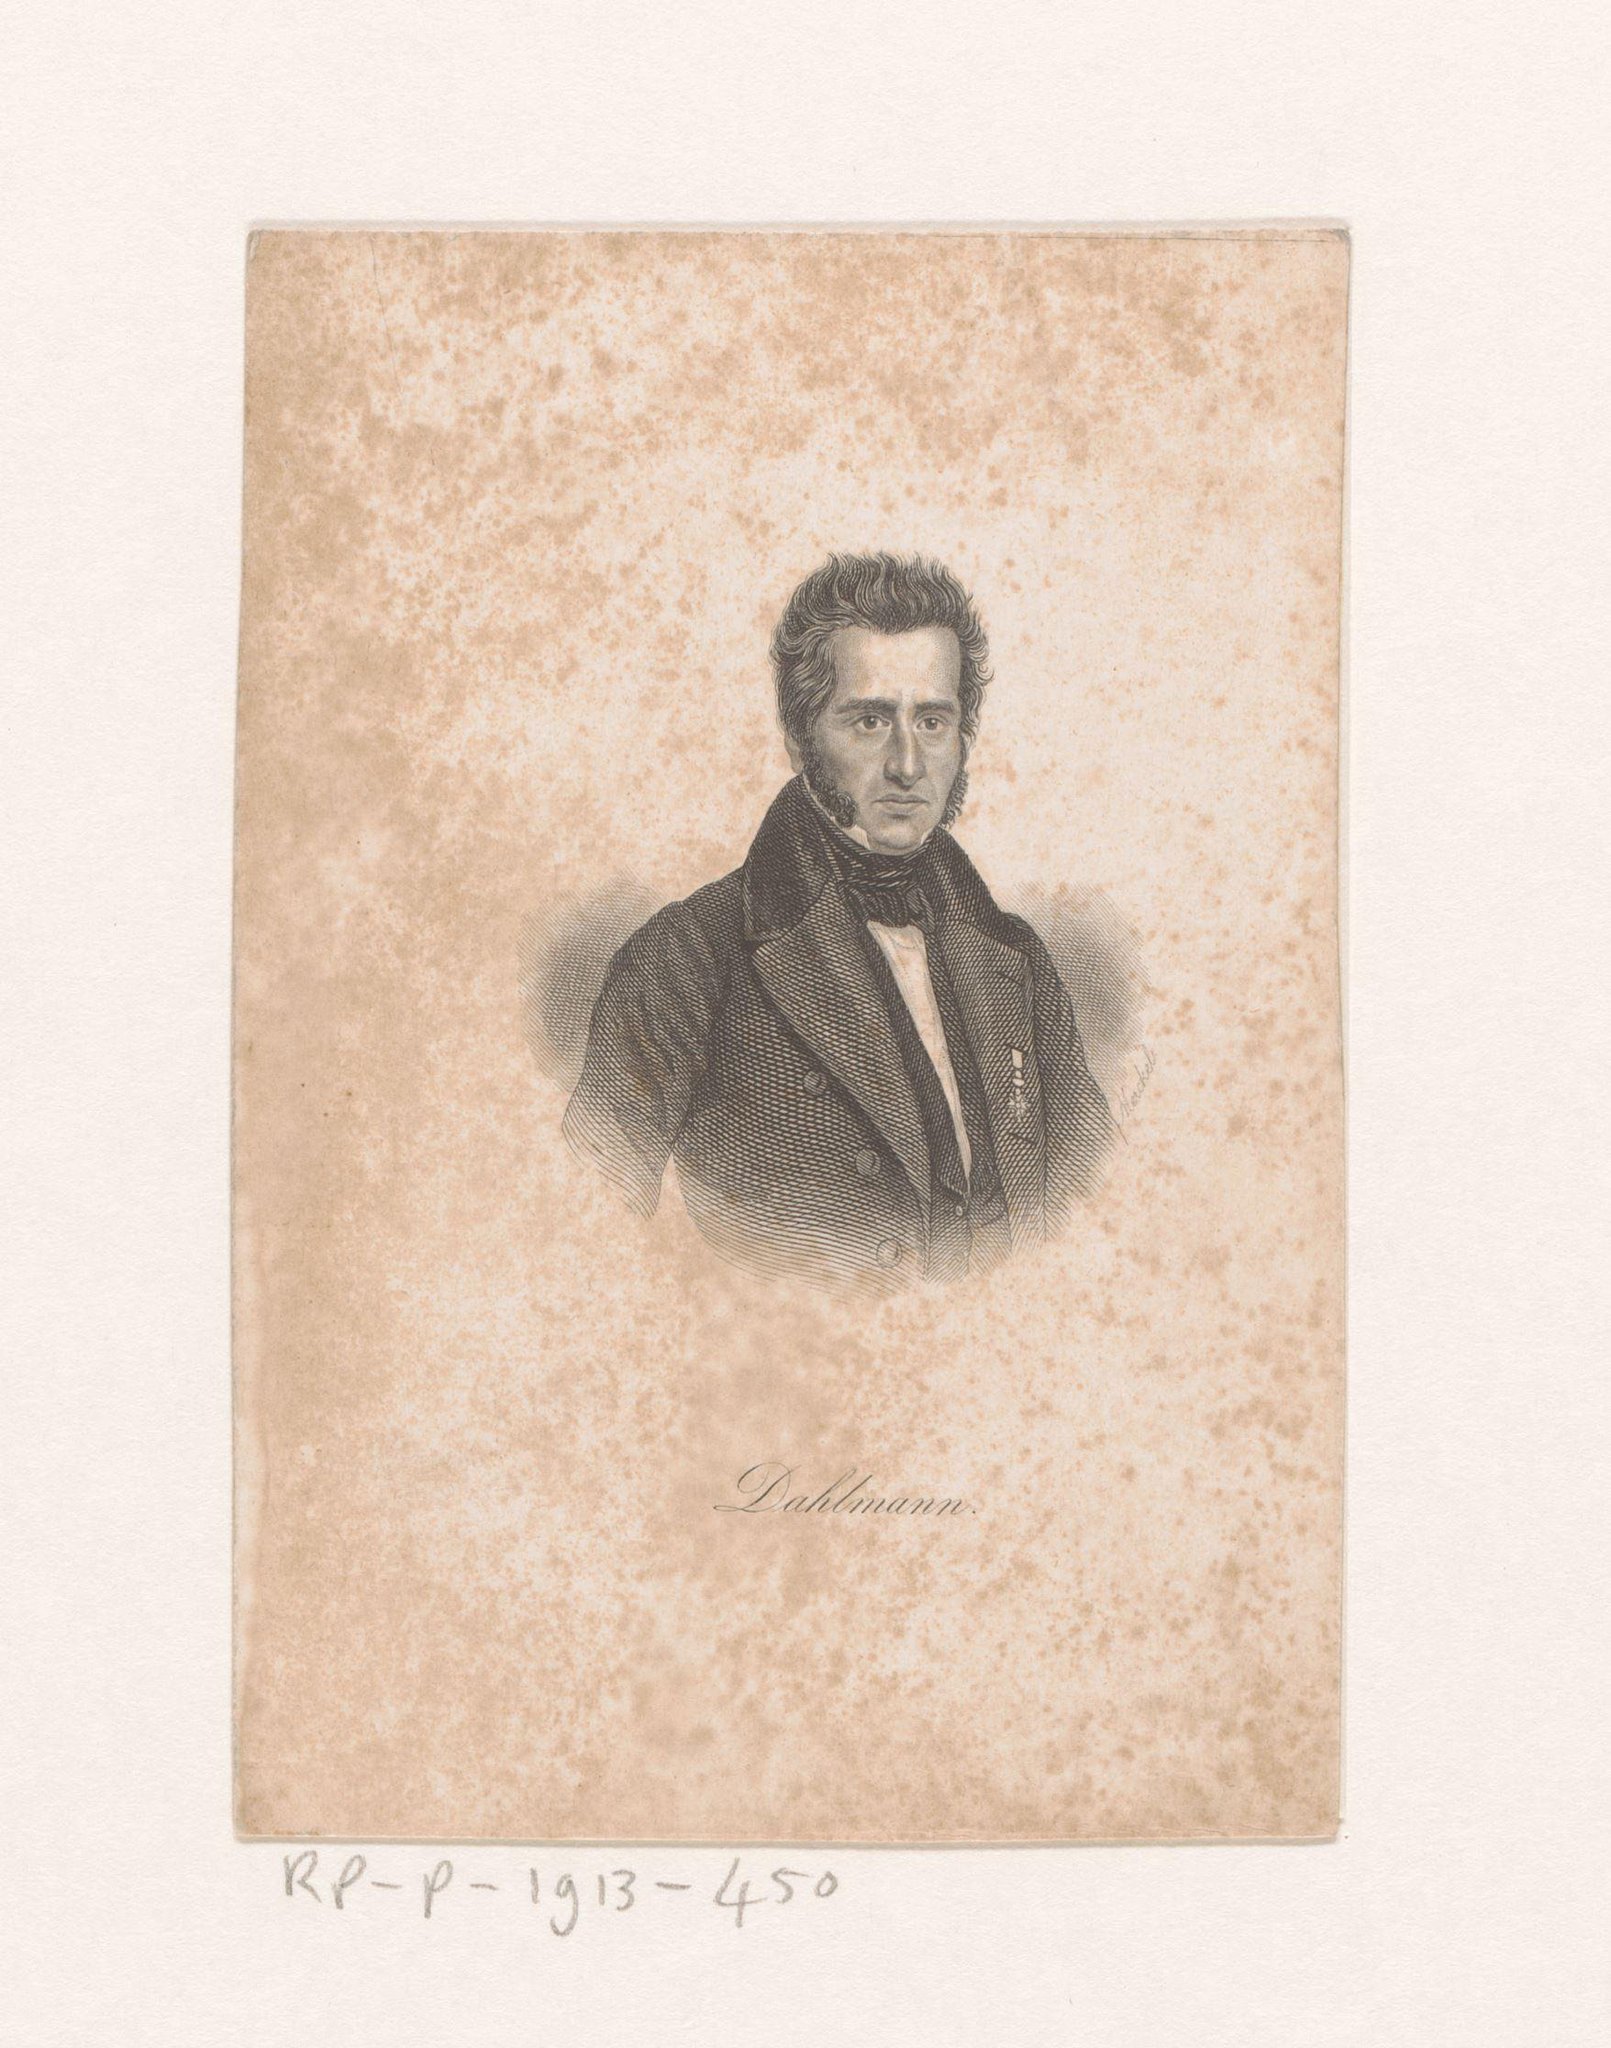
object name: print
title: Portret van Dohlmann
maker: conrad friedrich merckel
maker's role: print maker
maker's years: 1826-1880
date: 1836-1880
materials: paper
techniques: engraving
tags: historical persons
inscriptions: collector's mark: Lugt 2228